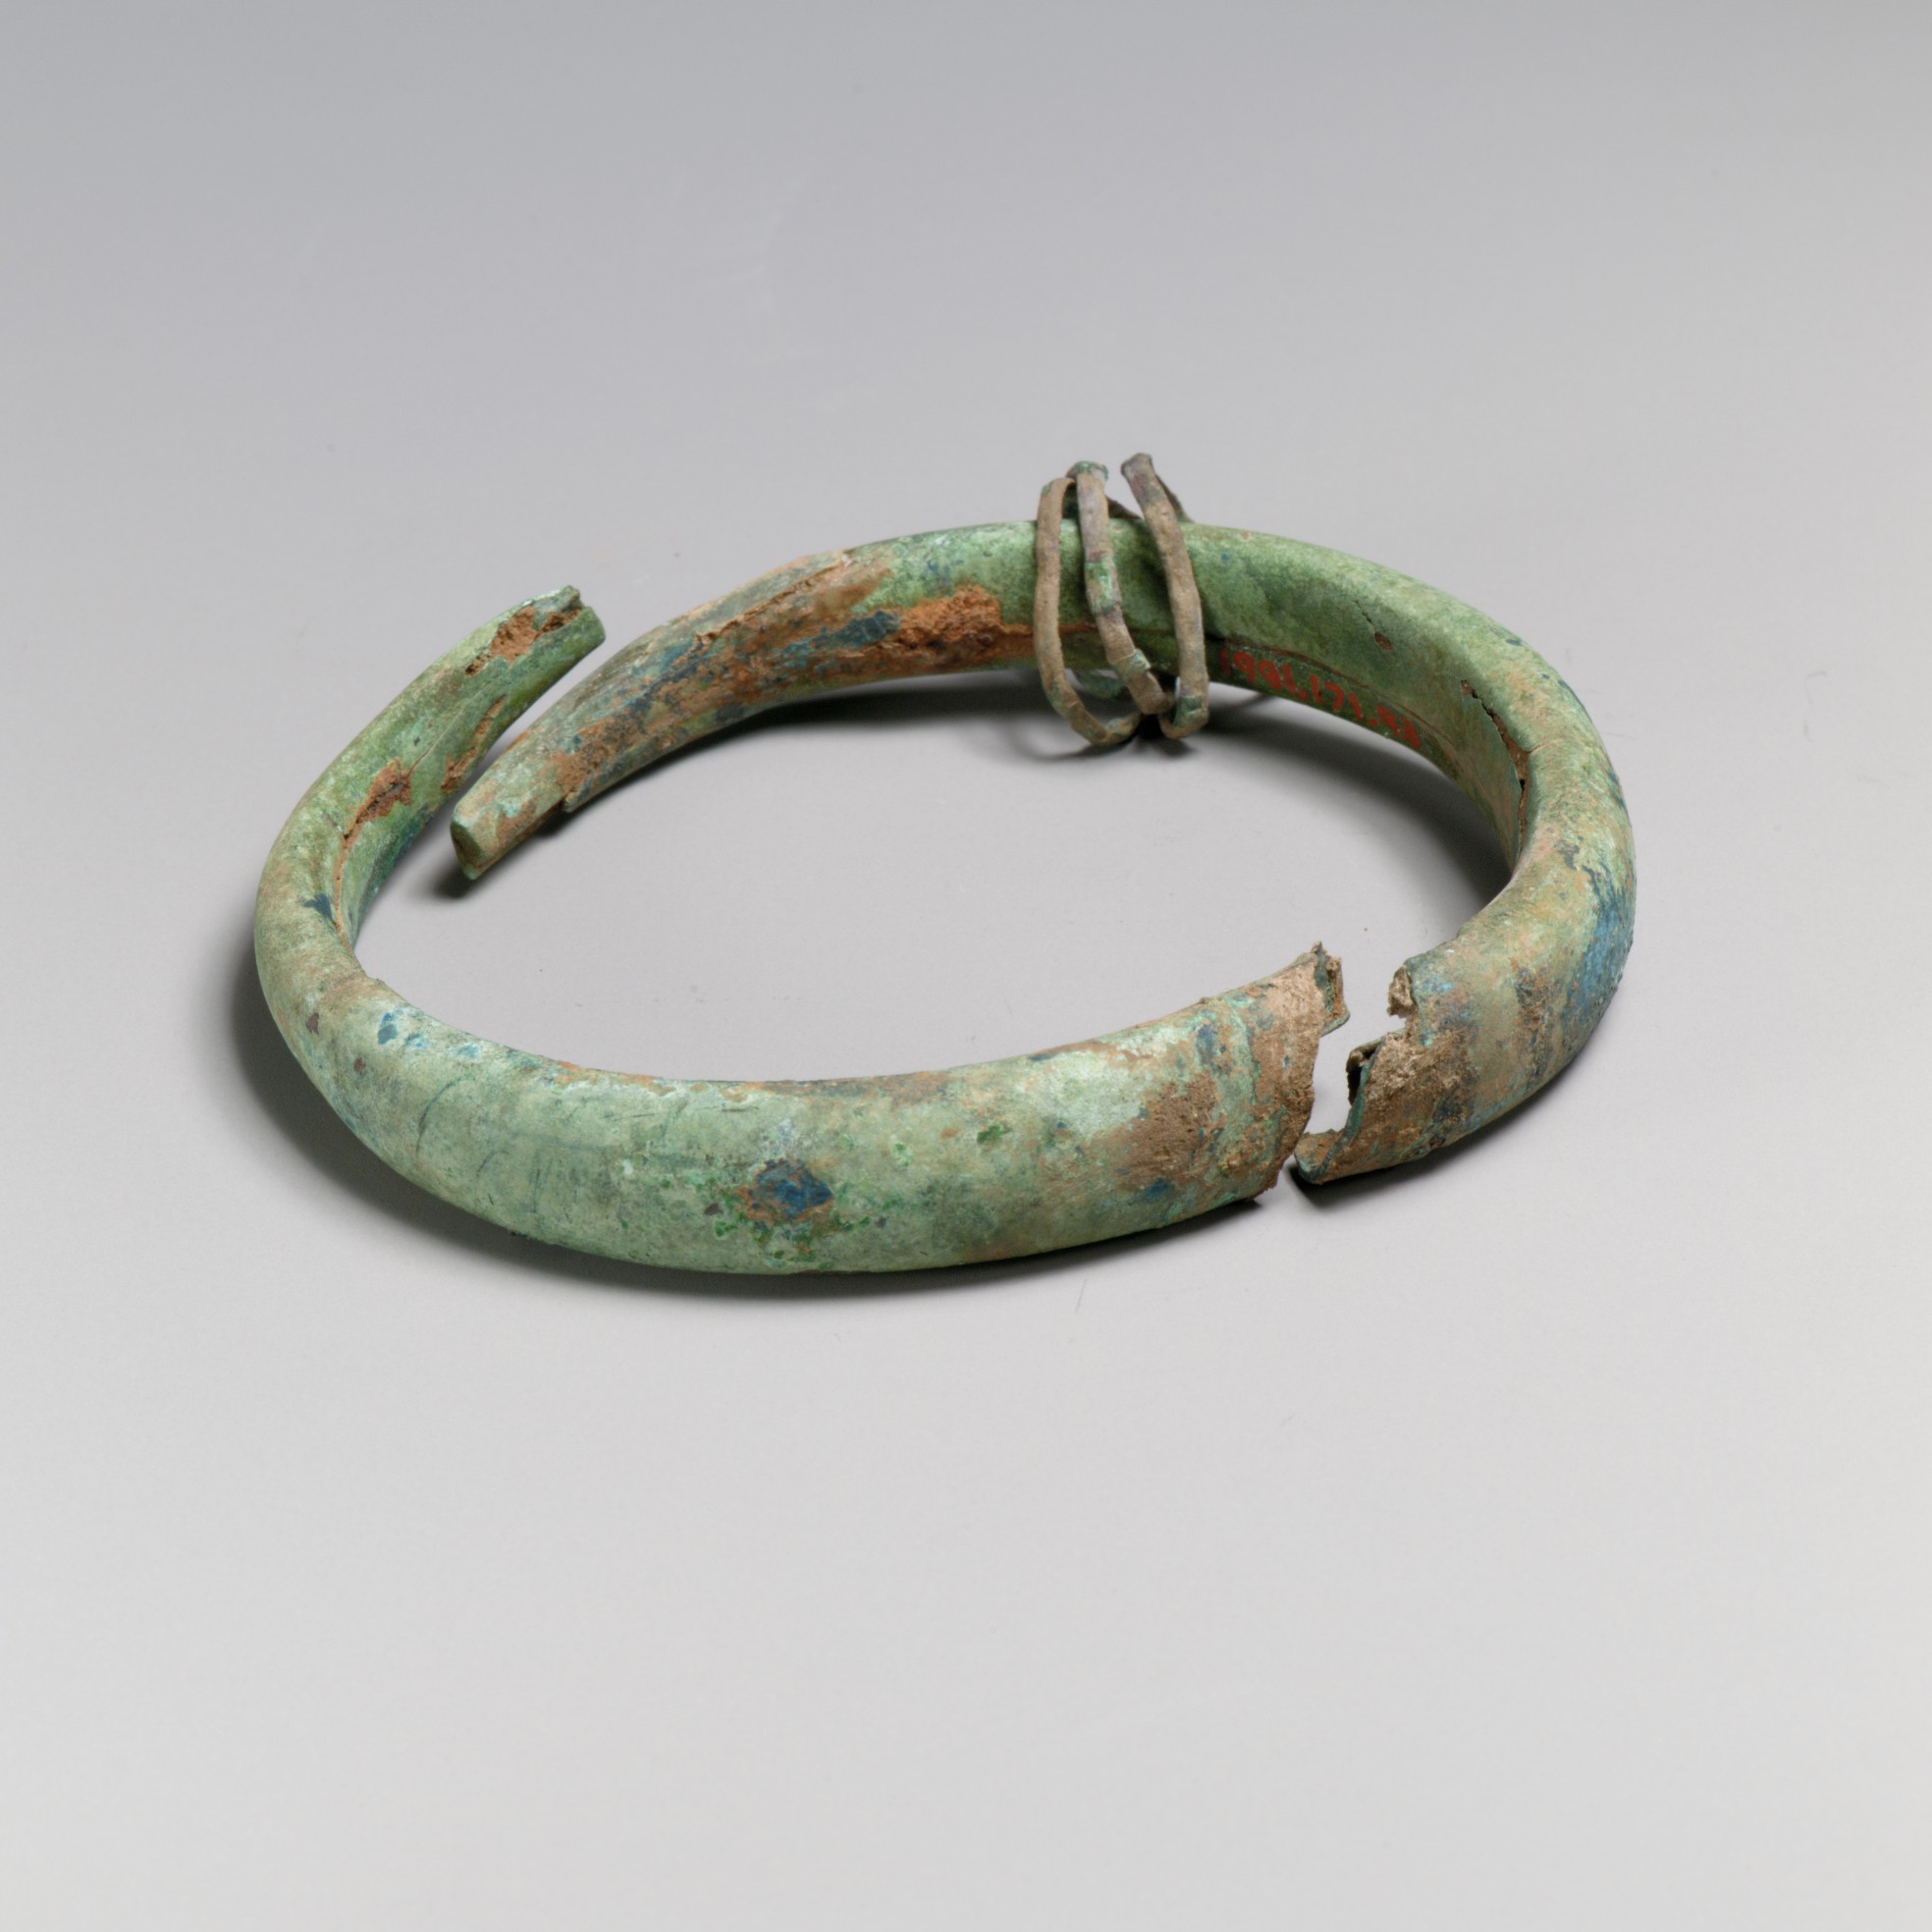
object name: bracelet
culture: italic, villanovan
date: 900-701 BCE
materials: bronze